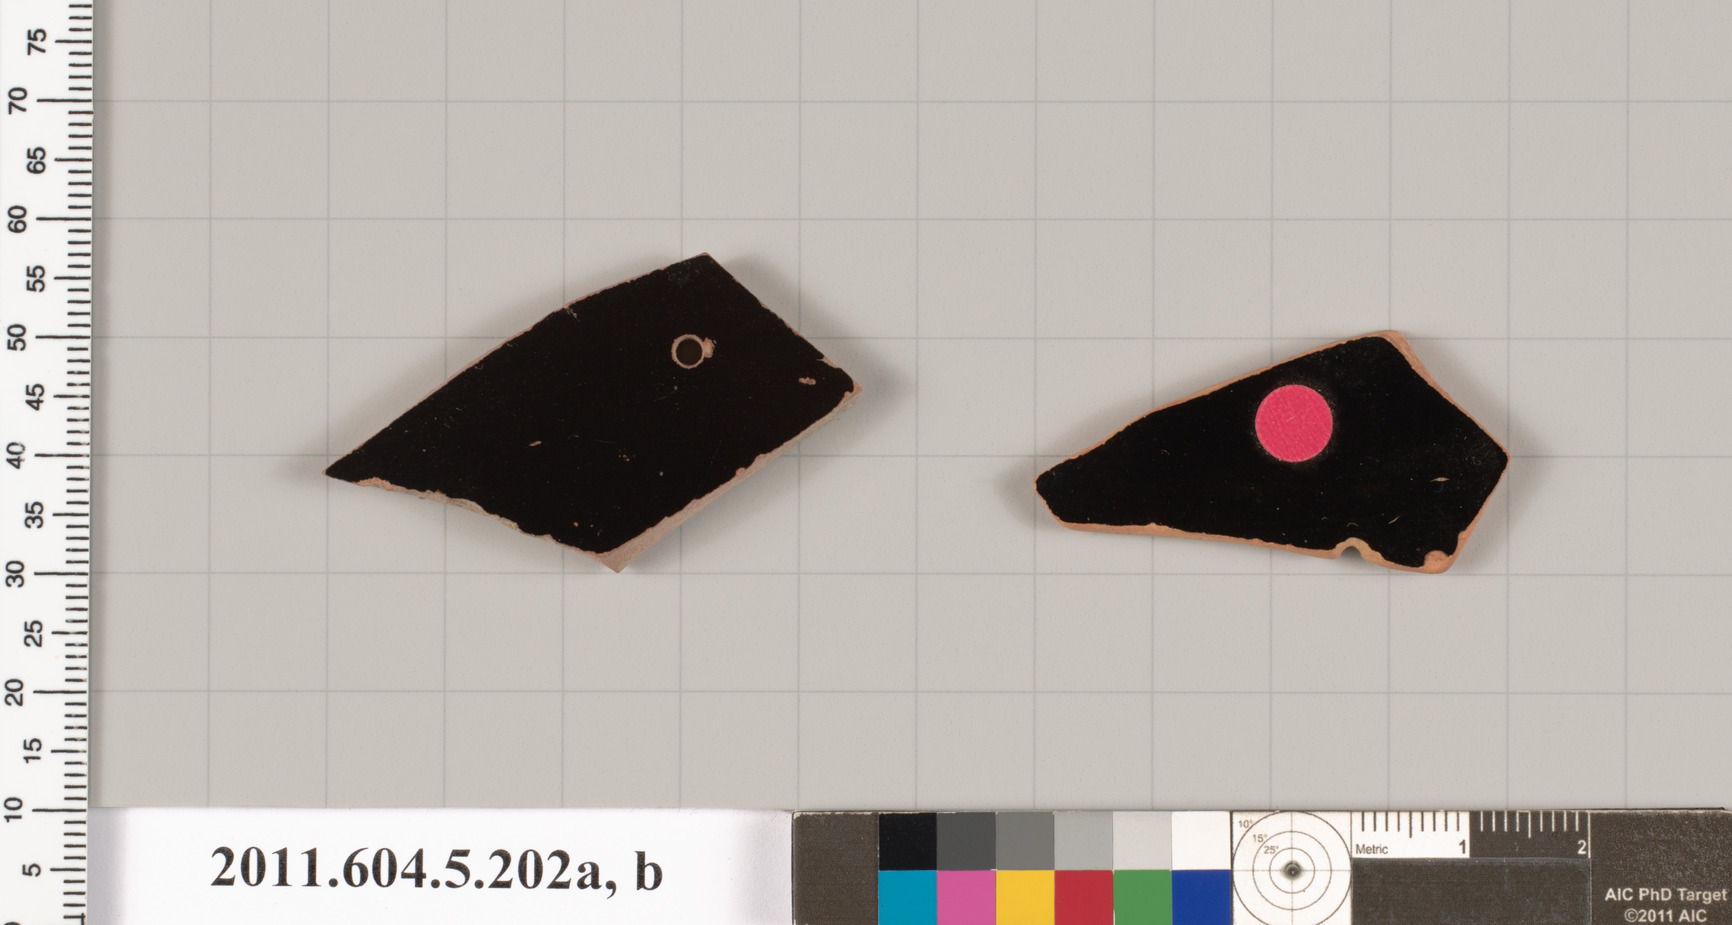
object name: kylix fragment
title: Terracotta fragments of kylikes (drinking cups)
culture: greek, attic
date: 600-401 BCE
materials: terracotta